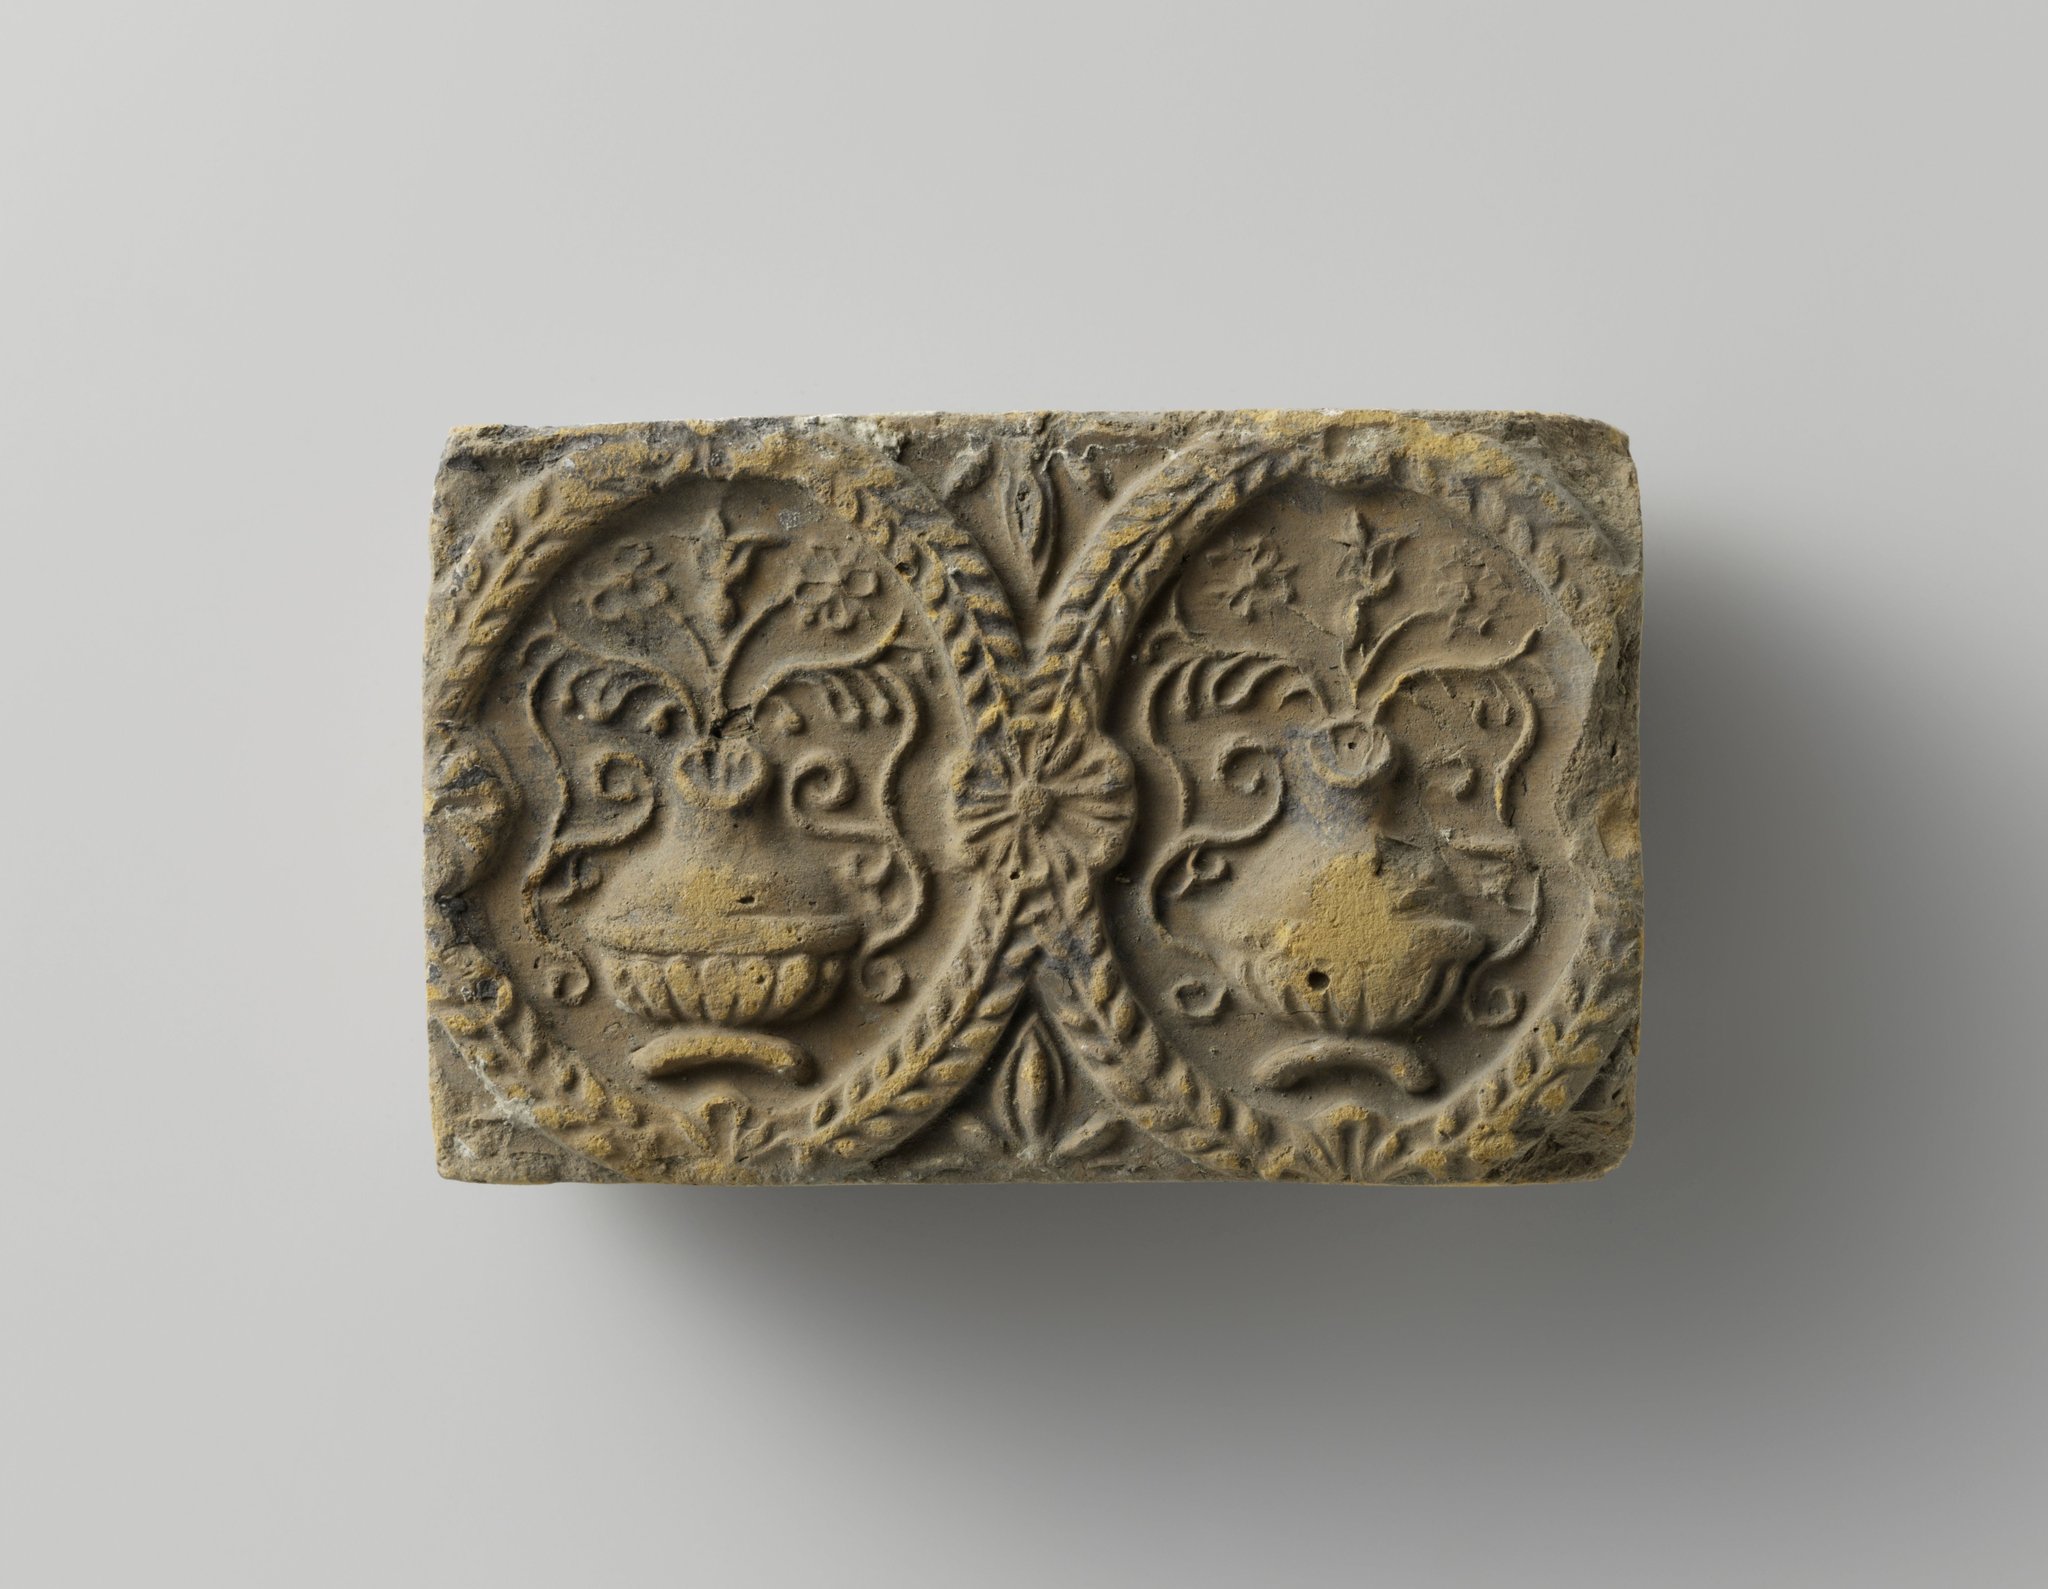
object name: architectural element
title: Haardsteen met een voorstelling van twee bloemenvazen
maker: Anonymous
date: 1600-1625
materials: earthenware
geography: southern netherlands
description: Haardsteen met een voorstelling van twee bloemenvazen, geplaatst in twee ovale lauwerkransen die door een rozet zijn verbonden.